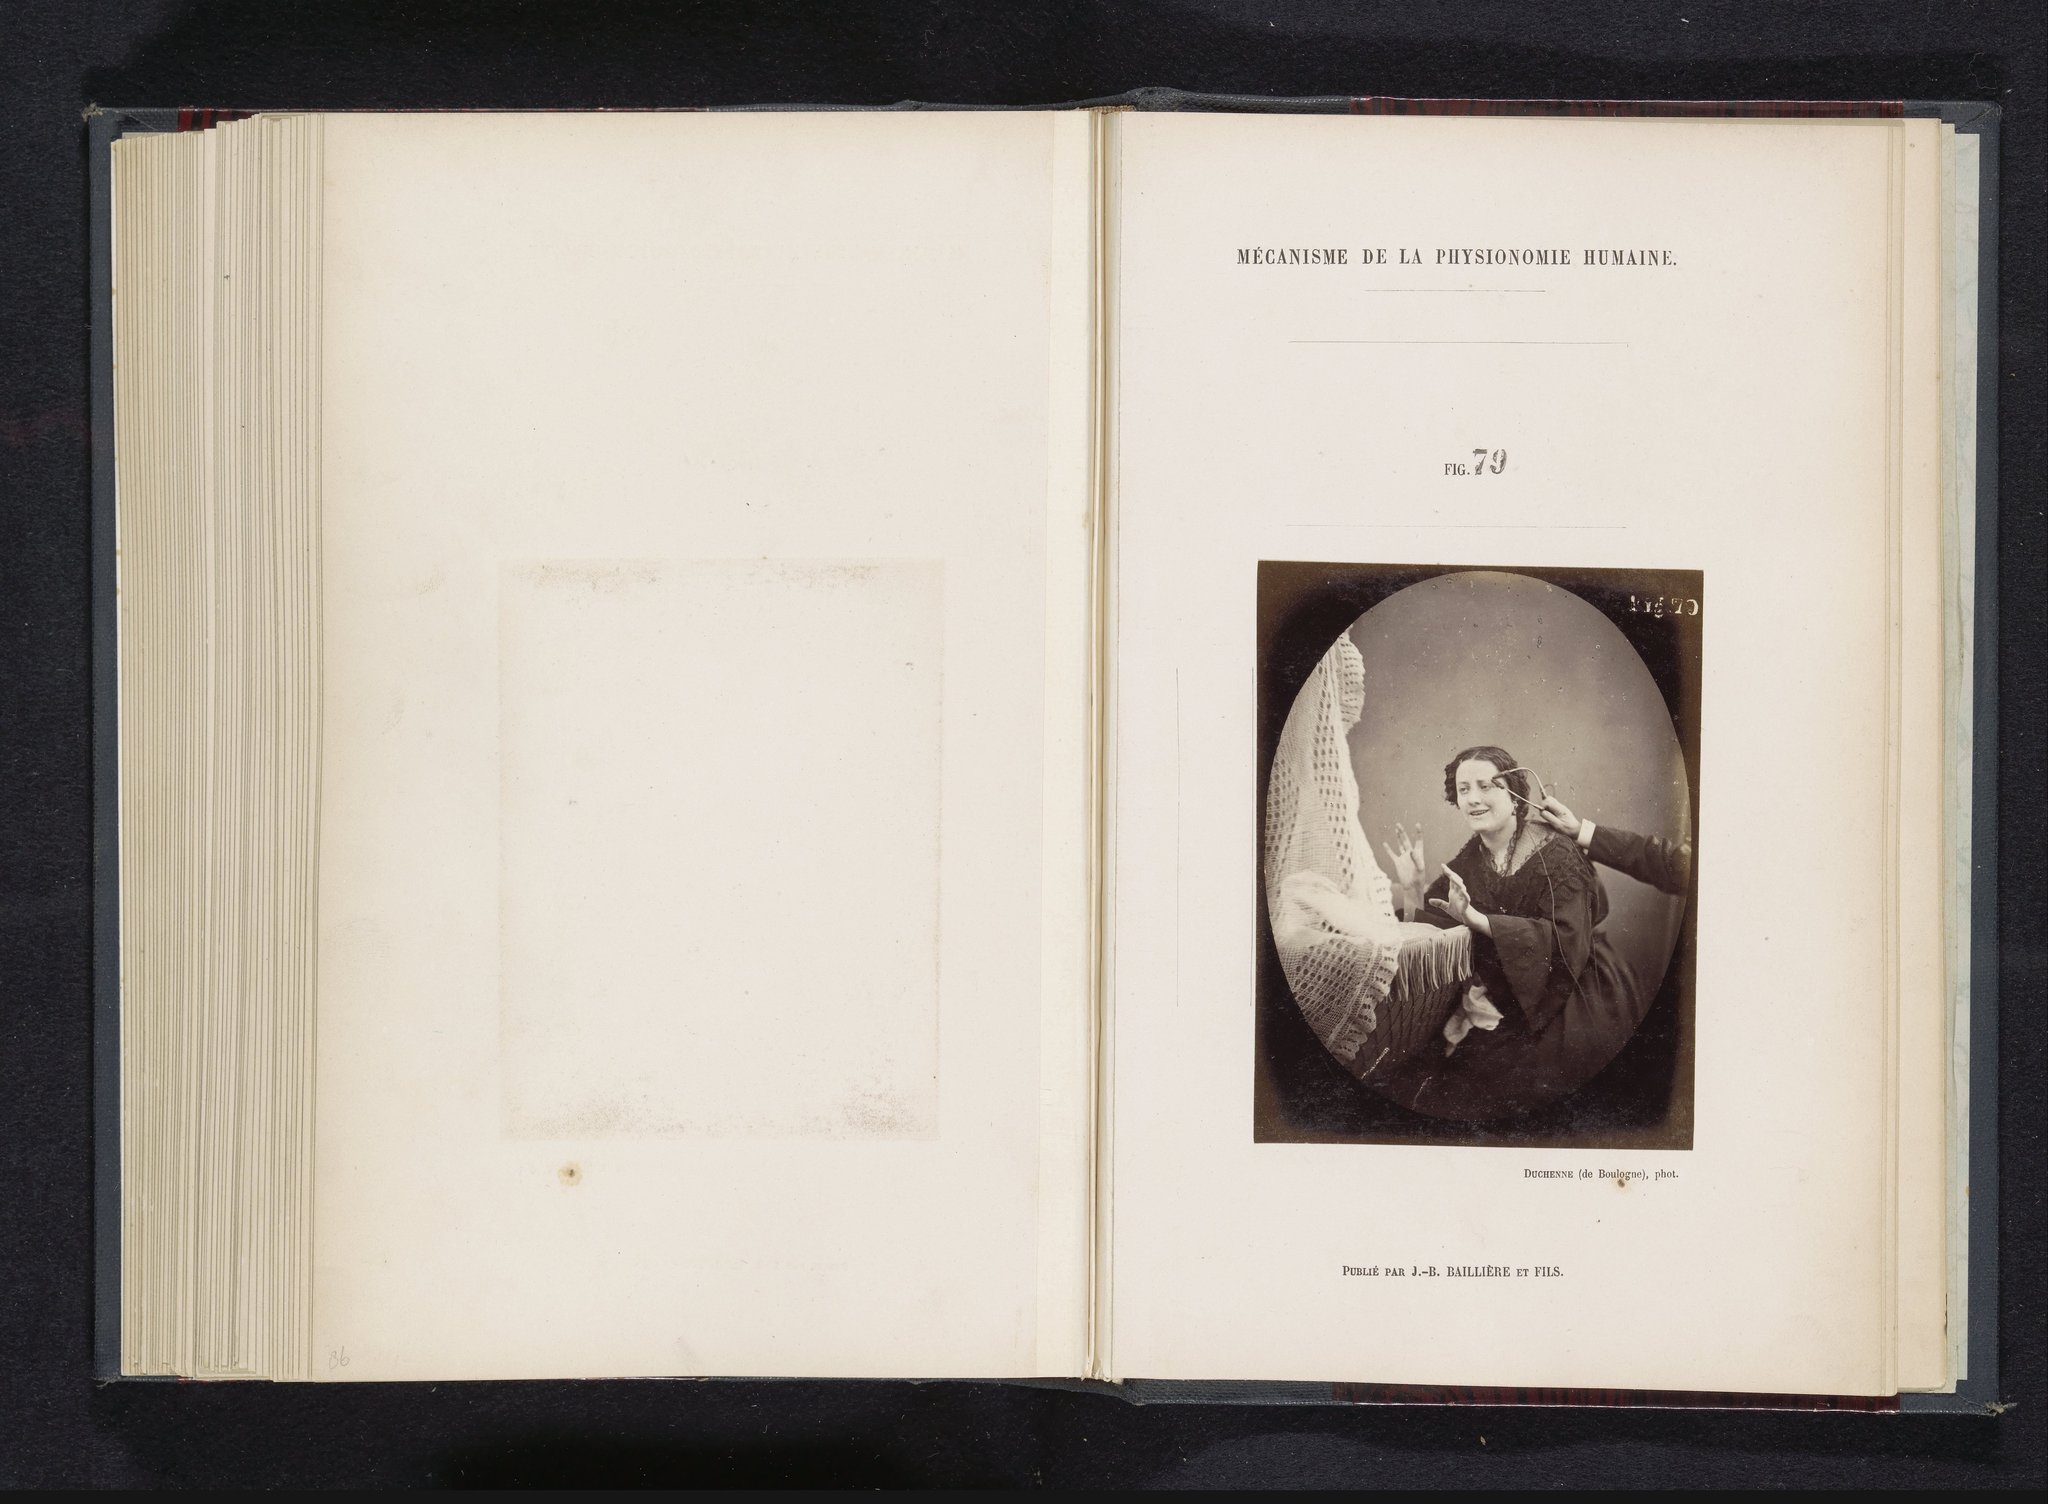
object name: photograph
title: Portret van een proefpersoon tijdens elektrostimulatie: 'une mère'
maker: guillaume benjamin amand duchenne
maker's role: fotograaf, medicus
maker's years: 1806-1875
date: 1860-1862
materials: paper, photographic support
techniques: albumen print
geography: paris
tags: face, adult woman, physiology and anatomy ~ nervous system, neurology, physiology and anatomy, morphology of facial expression, cradle, crib, physiognomy, experiment, test ~ science and technology, france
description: Ongenummerde pagina met foto 79 uit Mécanisme de la physionomie humaine ou analyse électro-physiologique de l'expression des passions (Atlas).